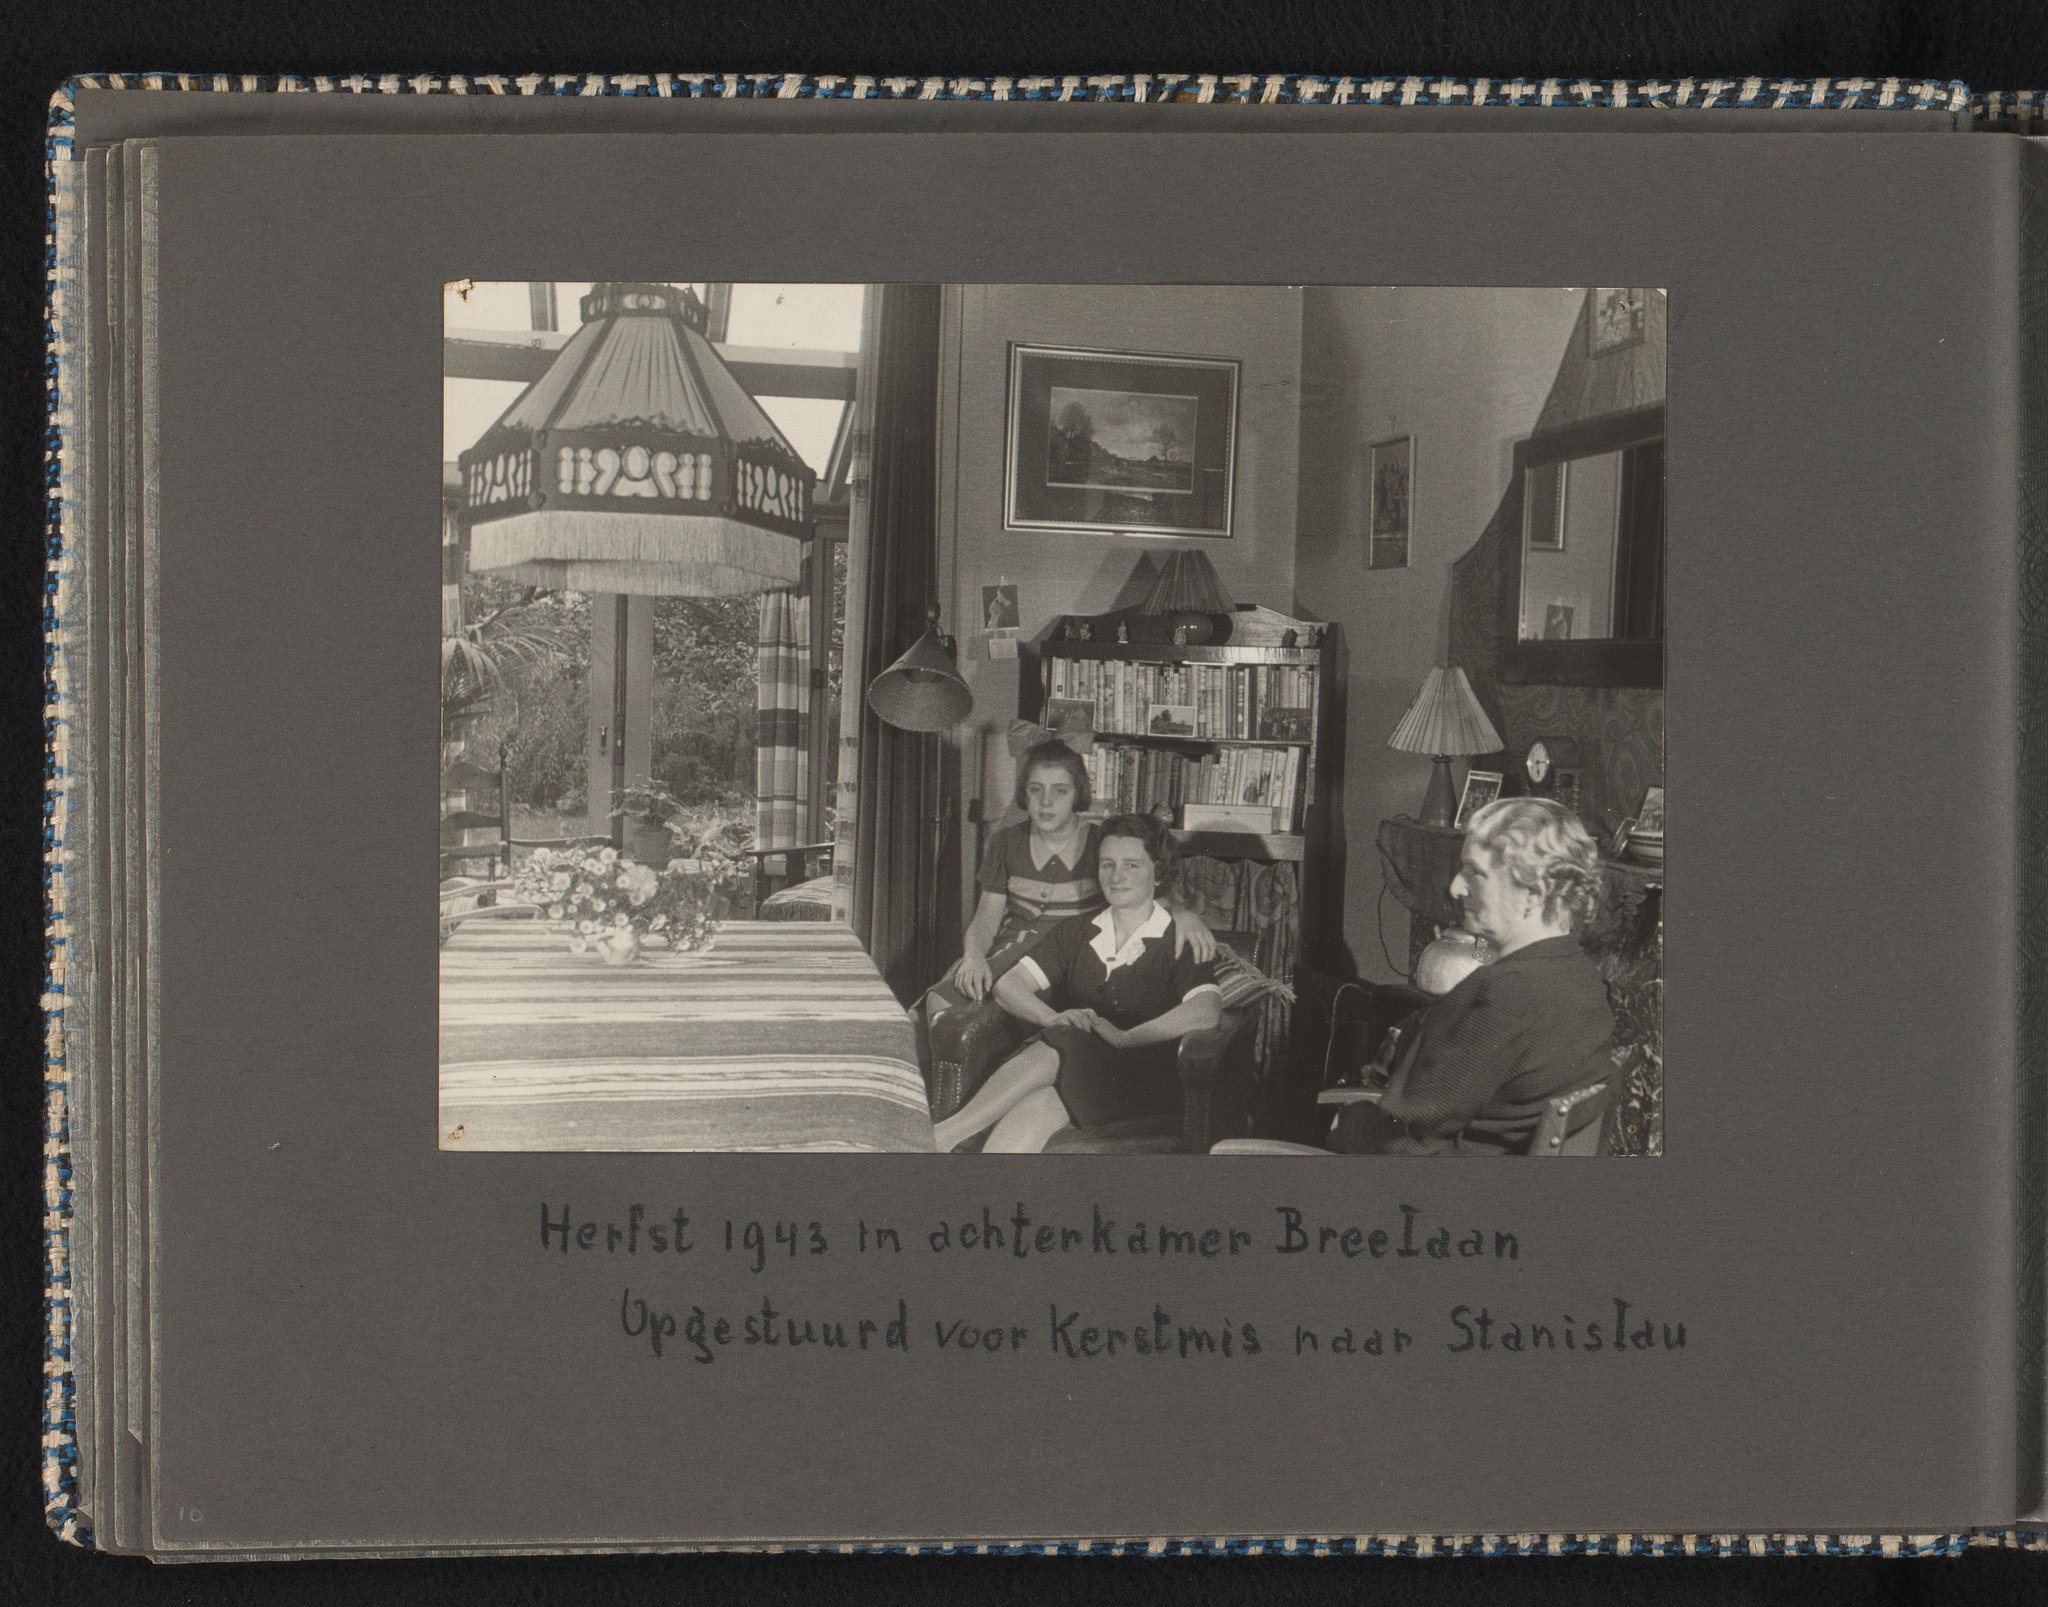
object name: photograph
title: Herfst 1943 in achterkamer Breelaan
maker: Anonymous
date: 1943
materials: paper, photographic support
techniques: gelatin silver print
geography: netherlands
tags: family life at home, mother and daughter(s) (family group), netherlands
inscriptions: inscription: ‘Herfst 1943 in achterkamer Breelaan / Opgestuurd voor Kerstmis naar Stanislau’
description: Albumblad met een foto van de moeder met dochter en een oudere vrouw, in de achterkamer van een woning, herfst 1943. Volgens het opschrift is de foto opgestuurd naar de echtgenoot/vader in krijgsgevangenschap. Onderdeel van het fotoalbum van het gezin van een Nederlandse officier in krijgsgevangenschap in Kamp Stanislau.